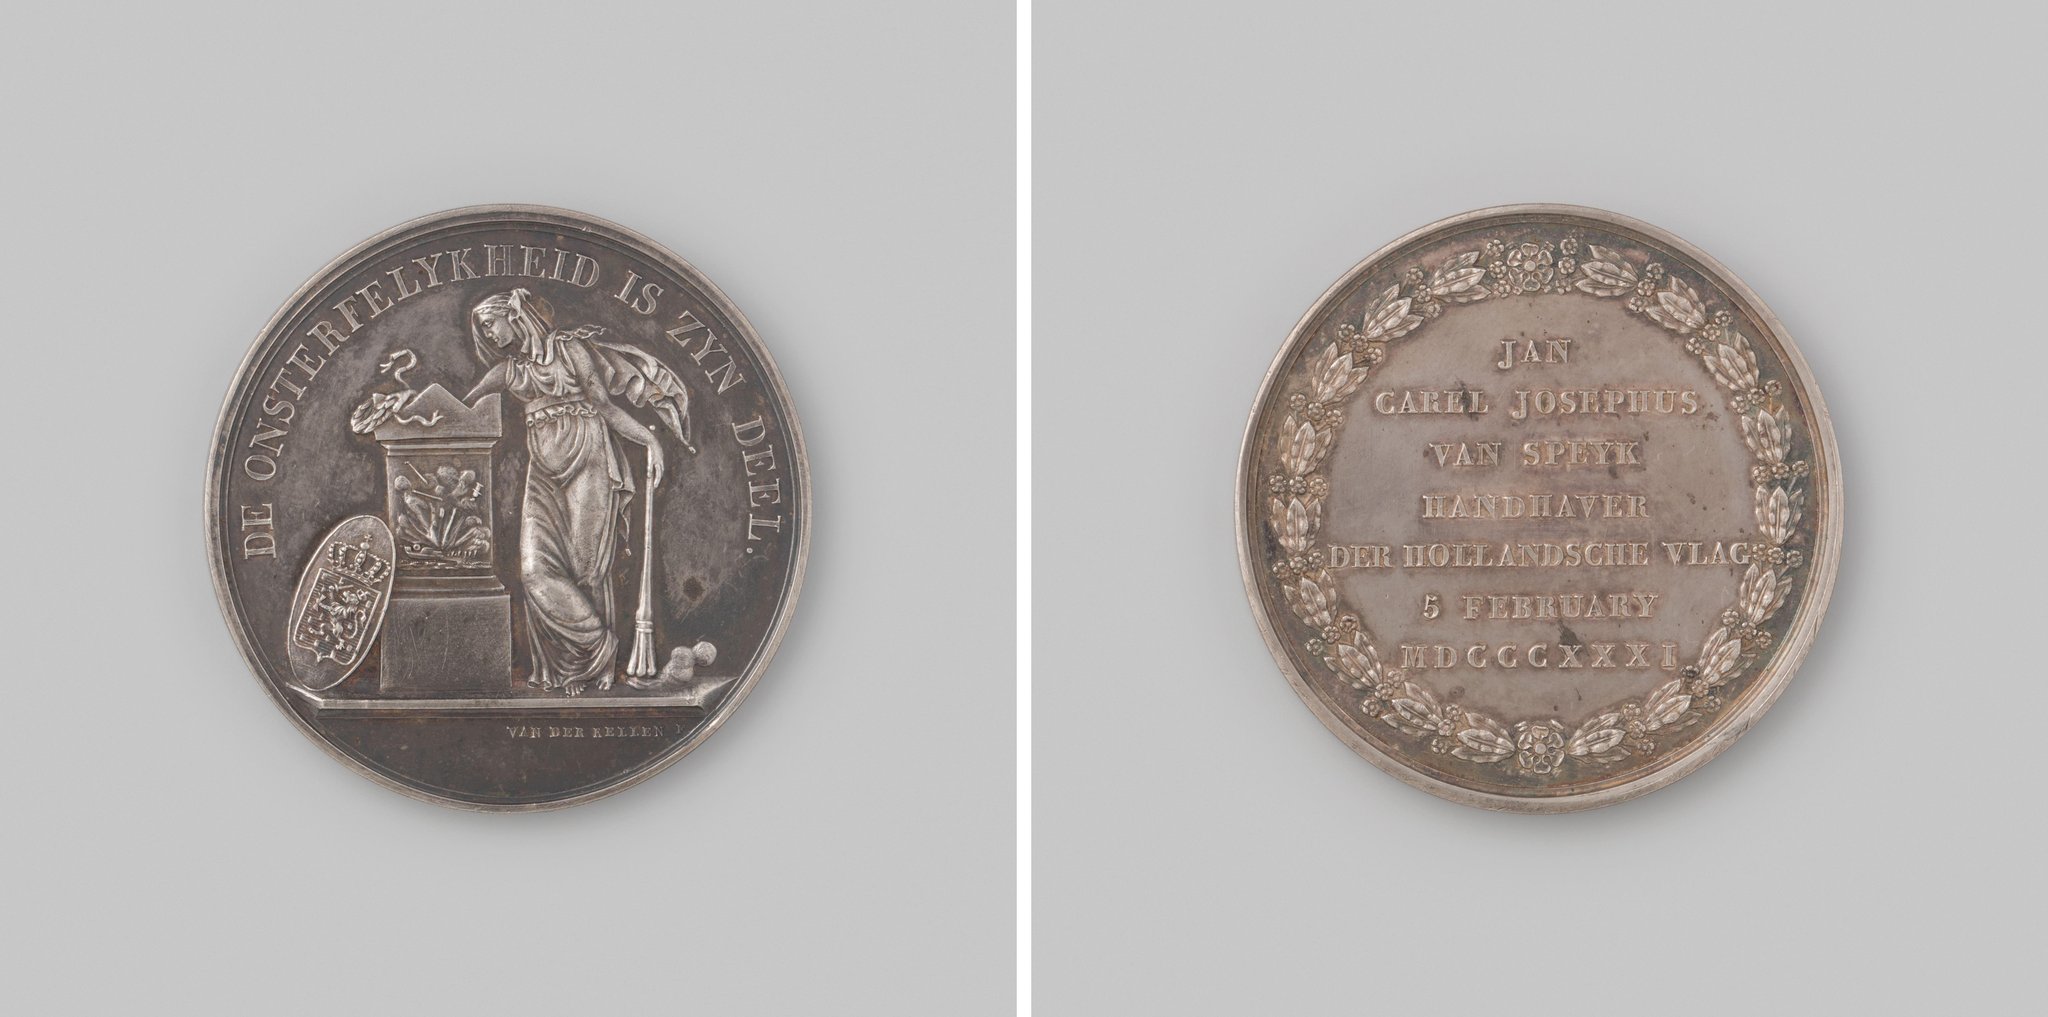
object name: history medal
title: Heldendood van Jan Carel Josephus van Speyk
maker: david van der kellen (1804-1879)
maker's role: die cutter, draughtsman, print maker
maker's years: 1804-1879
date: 1831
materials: silver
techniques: striking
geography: utrecht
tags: jan van speyk, antwerp